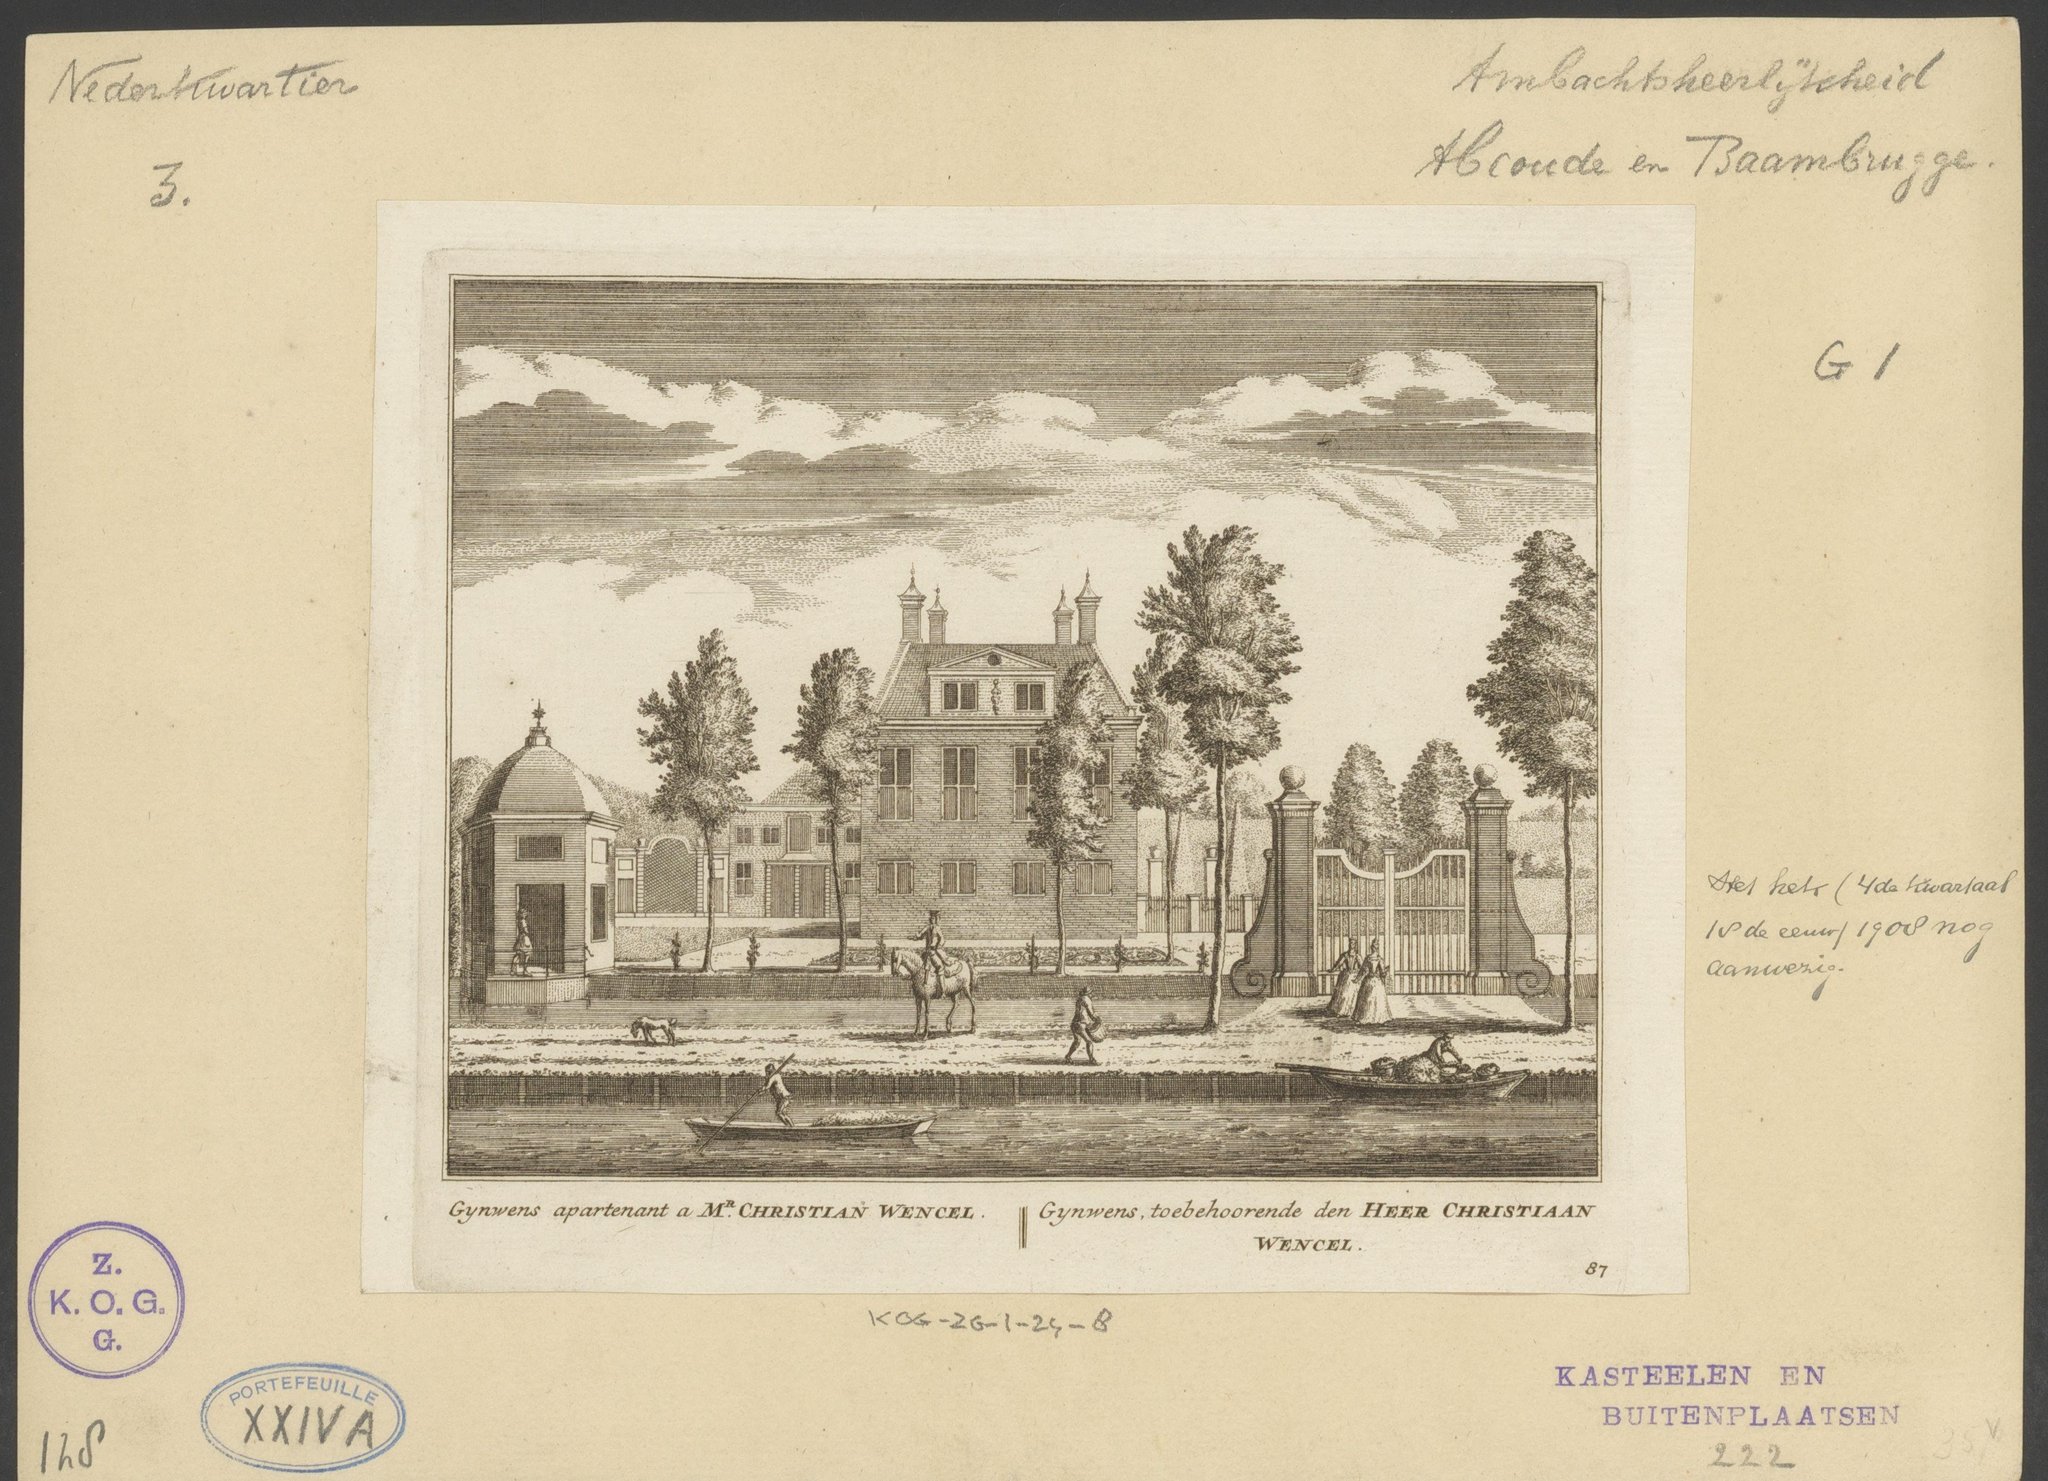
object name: book illustration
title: Gezicht op de buitenplaats Gijnwens, bij Baambrugge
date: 1730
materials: paper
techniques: etching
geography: amsterdam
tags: rural housing, e.g. country-house, villa, cottage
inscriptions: stamp, collector's mark: Lugt 1641, stamp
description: Rechtsonder genummerd: 87. Onderwerpsrubrieken binnen de Atlas Zeden en Gewoonten: Zeden en Gewoonten in Engeren Zin, De Woning. Kastelen en buitenplaatsen. Utrecht (vervolg.).